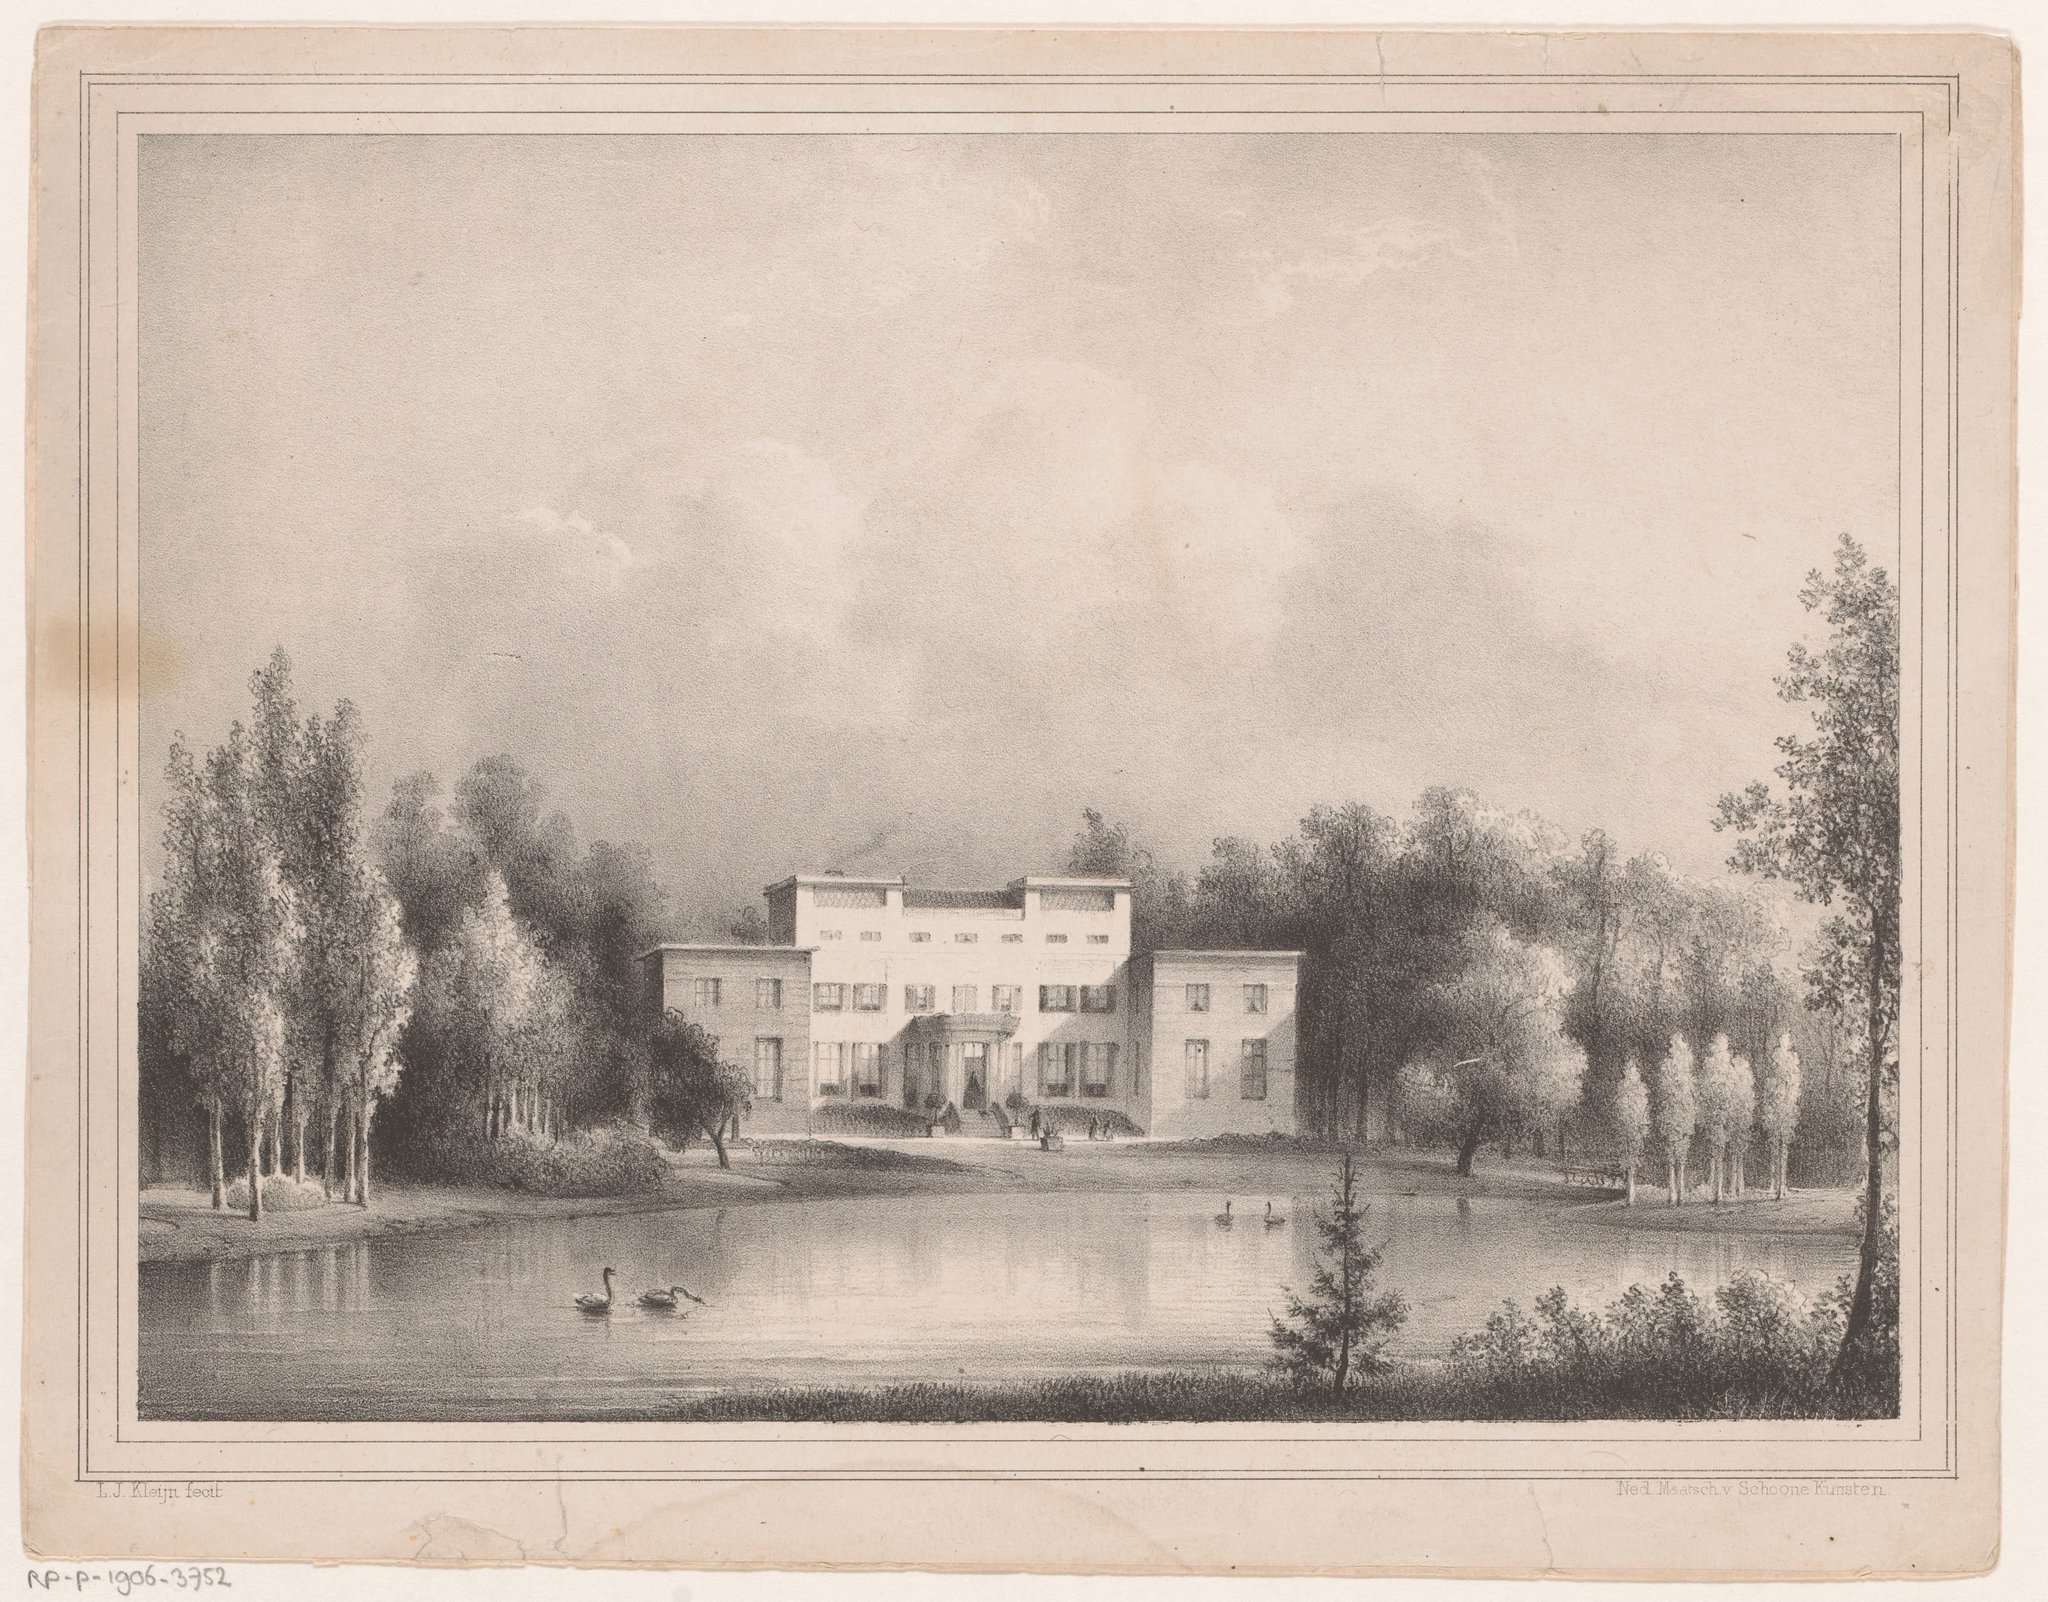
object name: print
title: Gezicht op de achterzijde van huize De Paauw te Wassenaar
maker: lodewijk johannes kleijn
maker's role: draughtsman, print maker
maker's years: 1817-1897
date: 1840-1843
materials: paper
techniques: lithograph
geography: the hague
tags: villa, garden pond, country-house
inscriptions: collector's mark: Lugt 2228